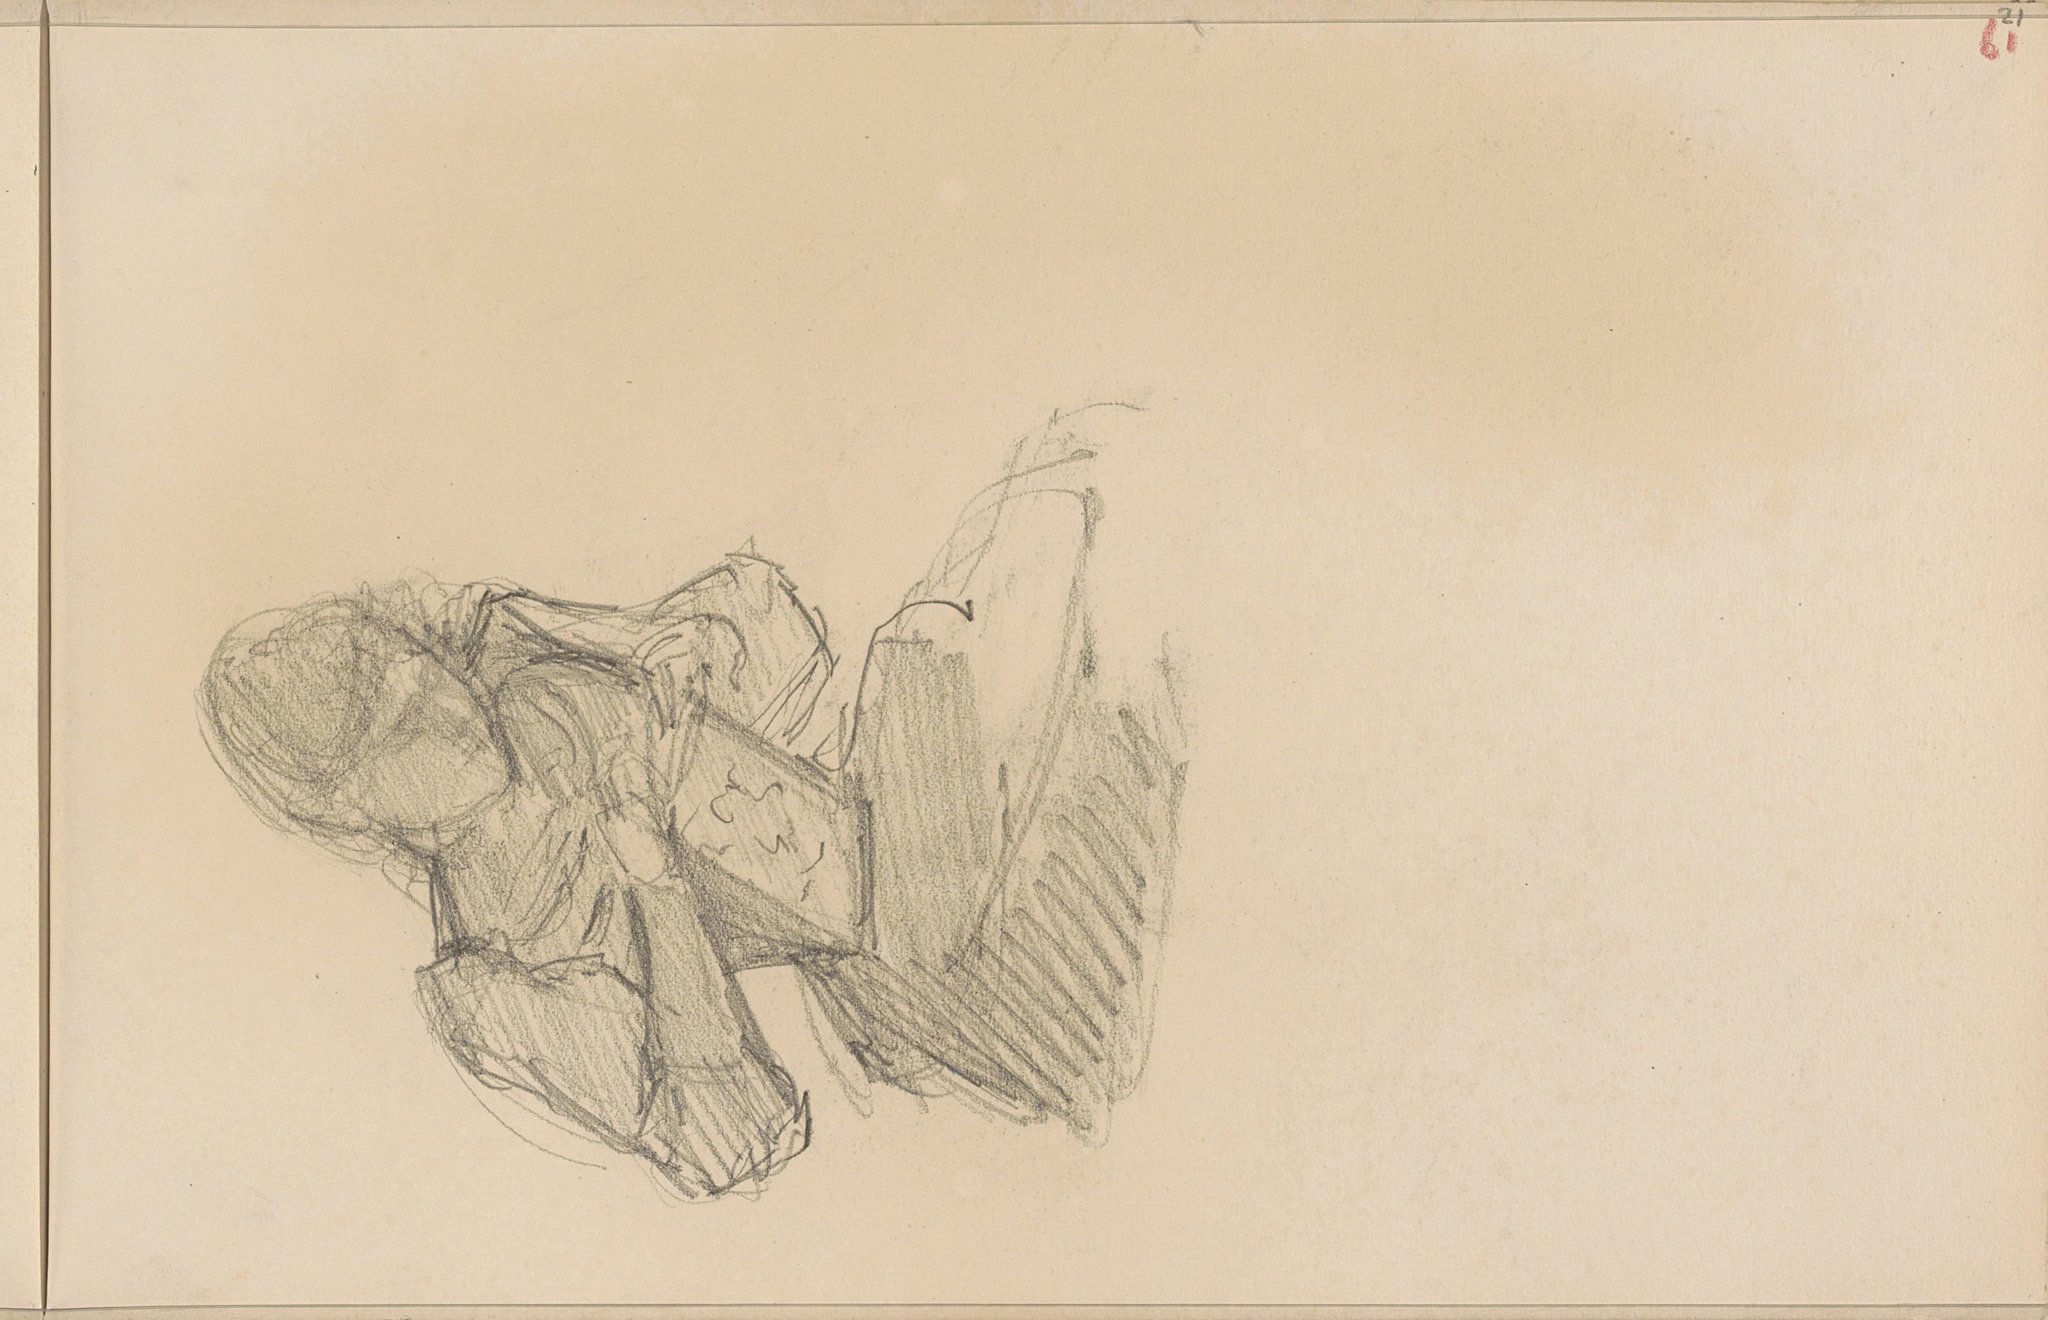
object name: sketchbook leaf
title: Vrouw met een borduurwerk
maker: jozef israëls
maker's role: draughtsman, painter, print maker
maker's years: 1824-1911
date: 1834-1911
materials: paper, pencil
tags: (other forms of) needlework, e.g.: crocheting, knitting, embroidering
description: Blad 21 recto uit een schetsboek met 25 bladen.